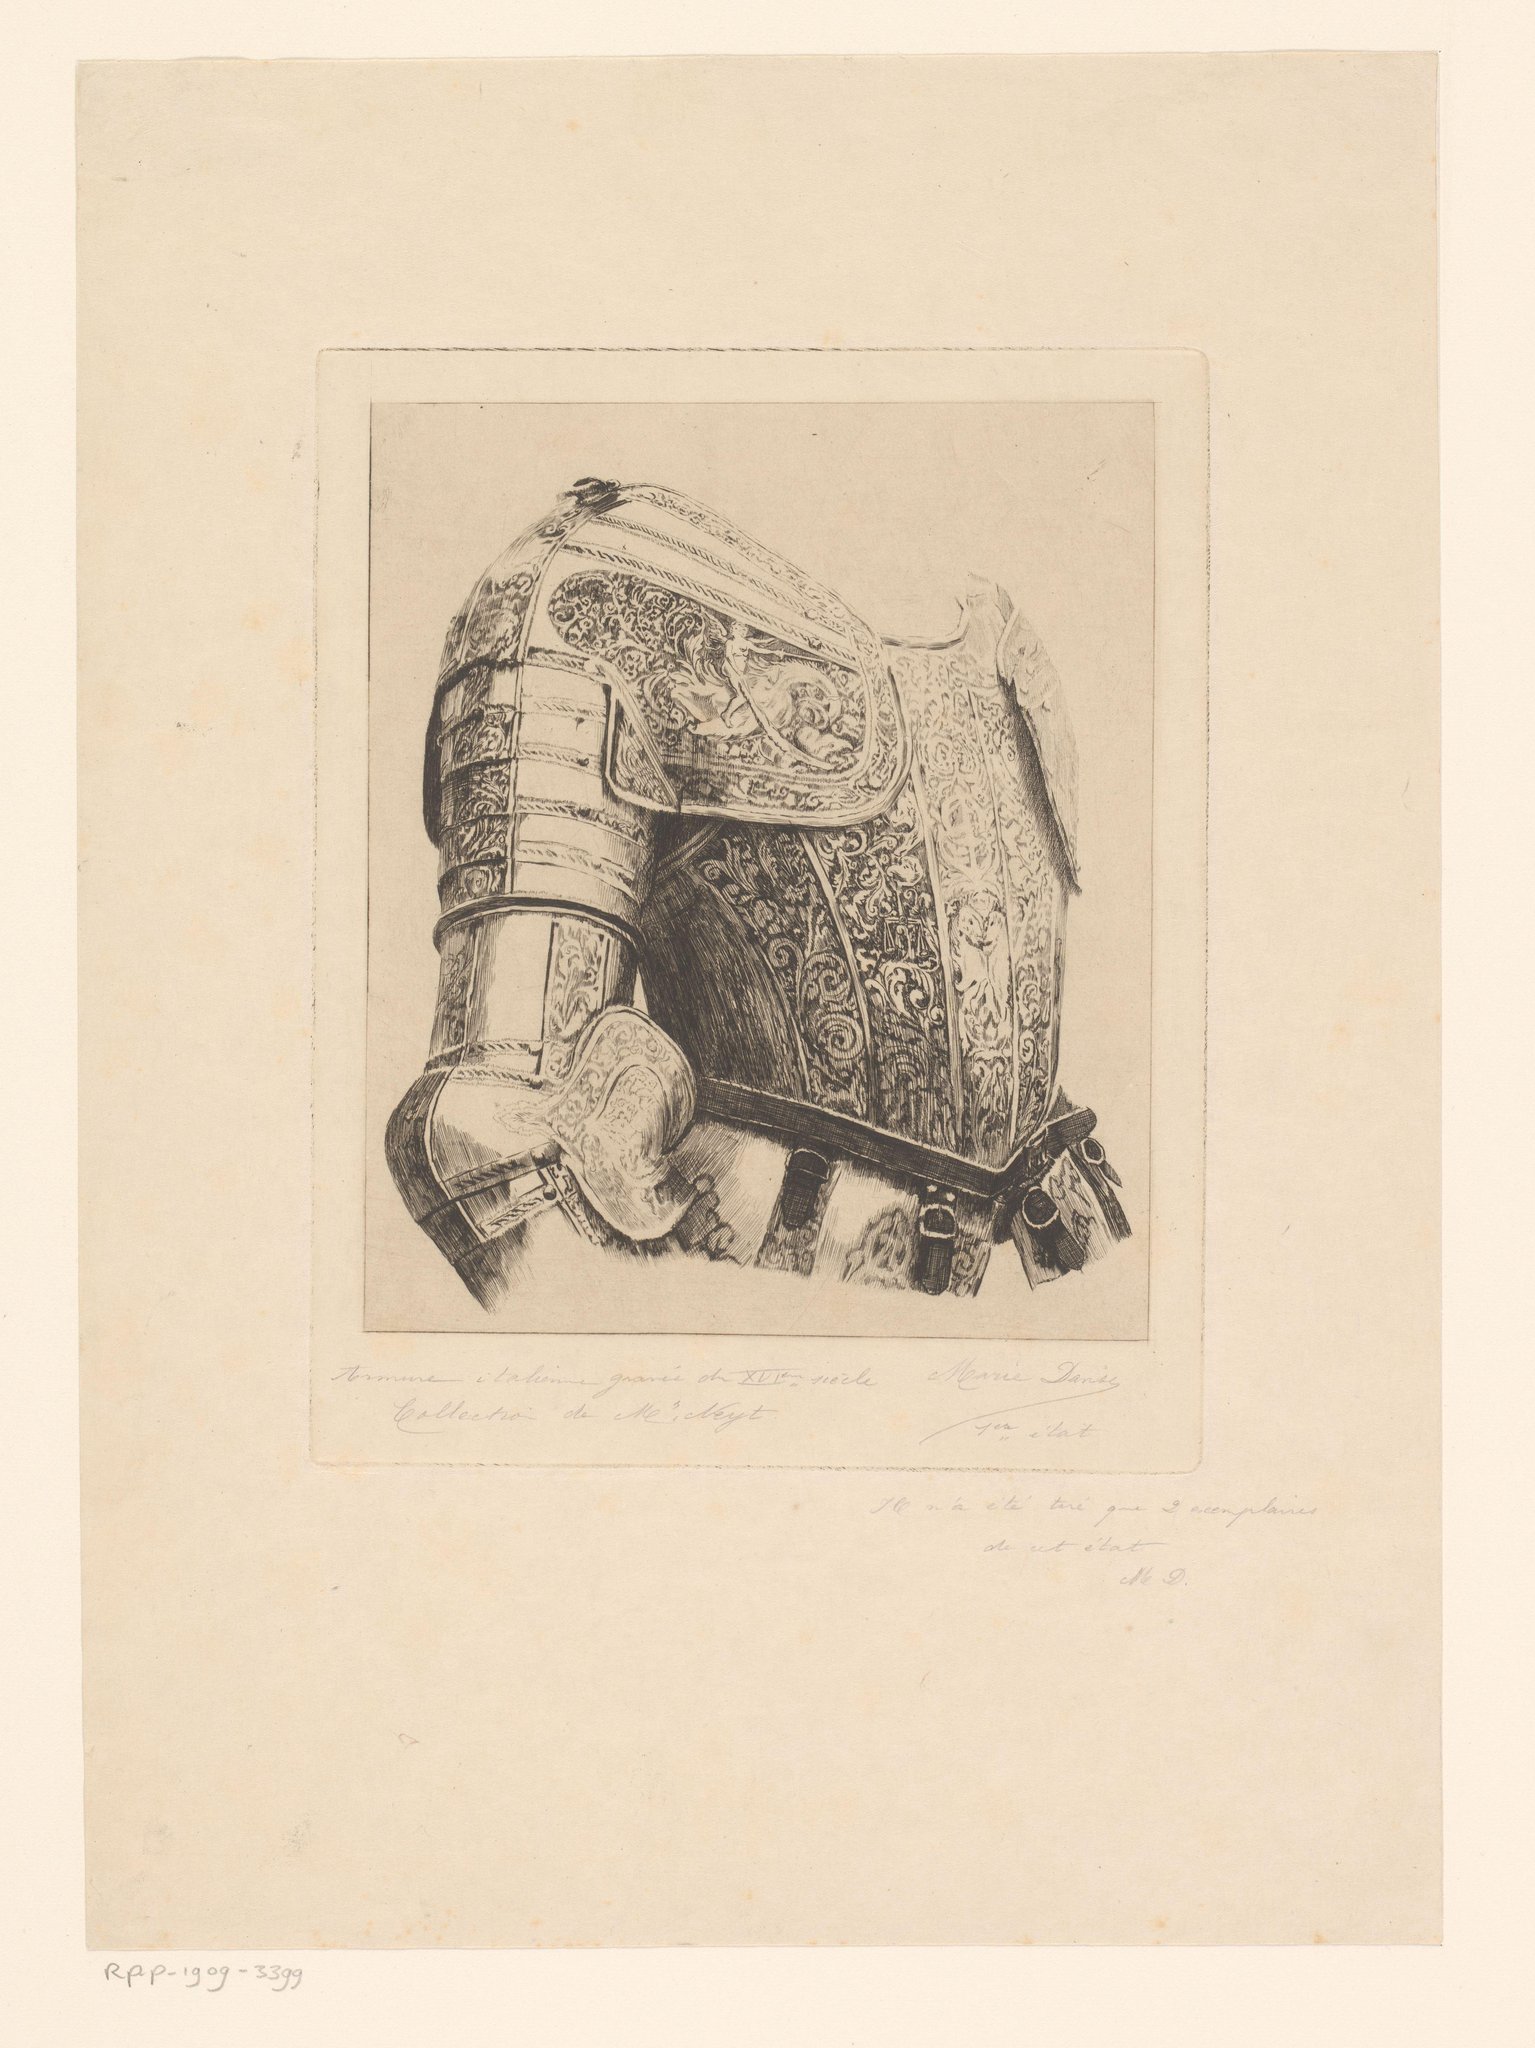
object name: print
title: Zestiende-eeuws, gegraveerd harnas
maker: marie danse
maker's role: print maker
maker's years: 1867-1942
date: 1887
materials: paper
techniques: etching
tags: cuirass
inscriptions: inscription: ‘Armure italienne gravée an XVIe siècle; Collection de Mr. Neyt; 1 em état; I le n à été tire que 2 exemplaires de ut état’, collector's mark: Lugt 2228